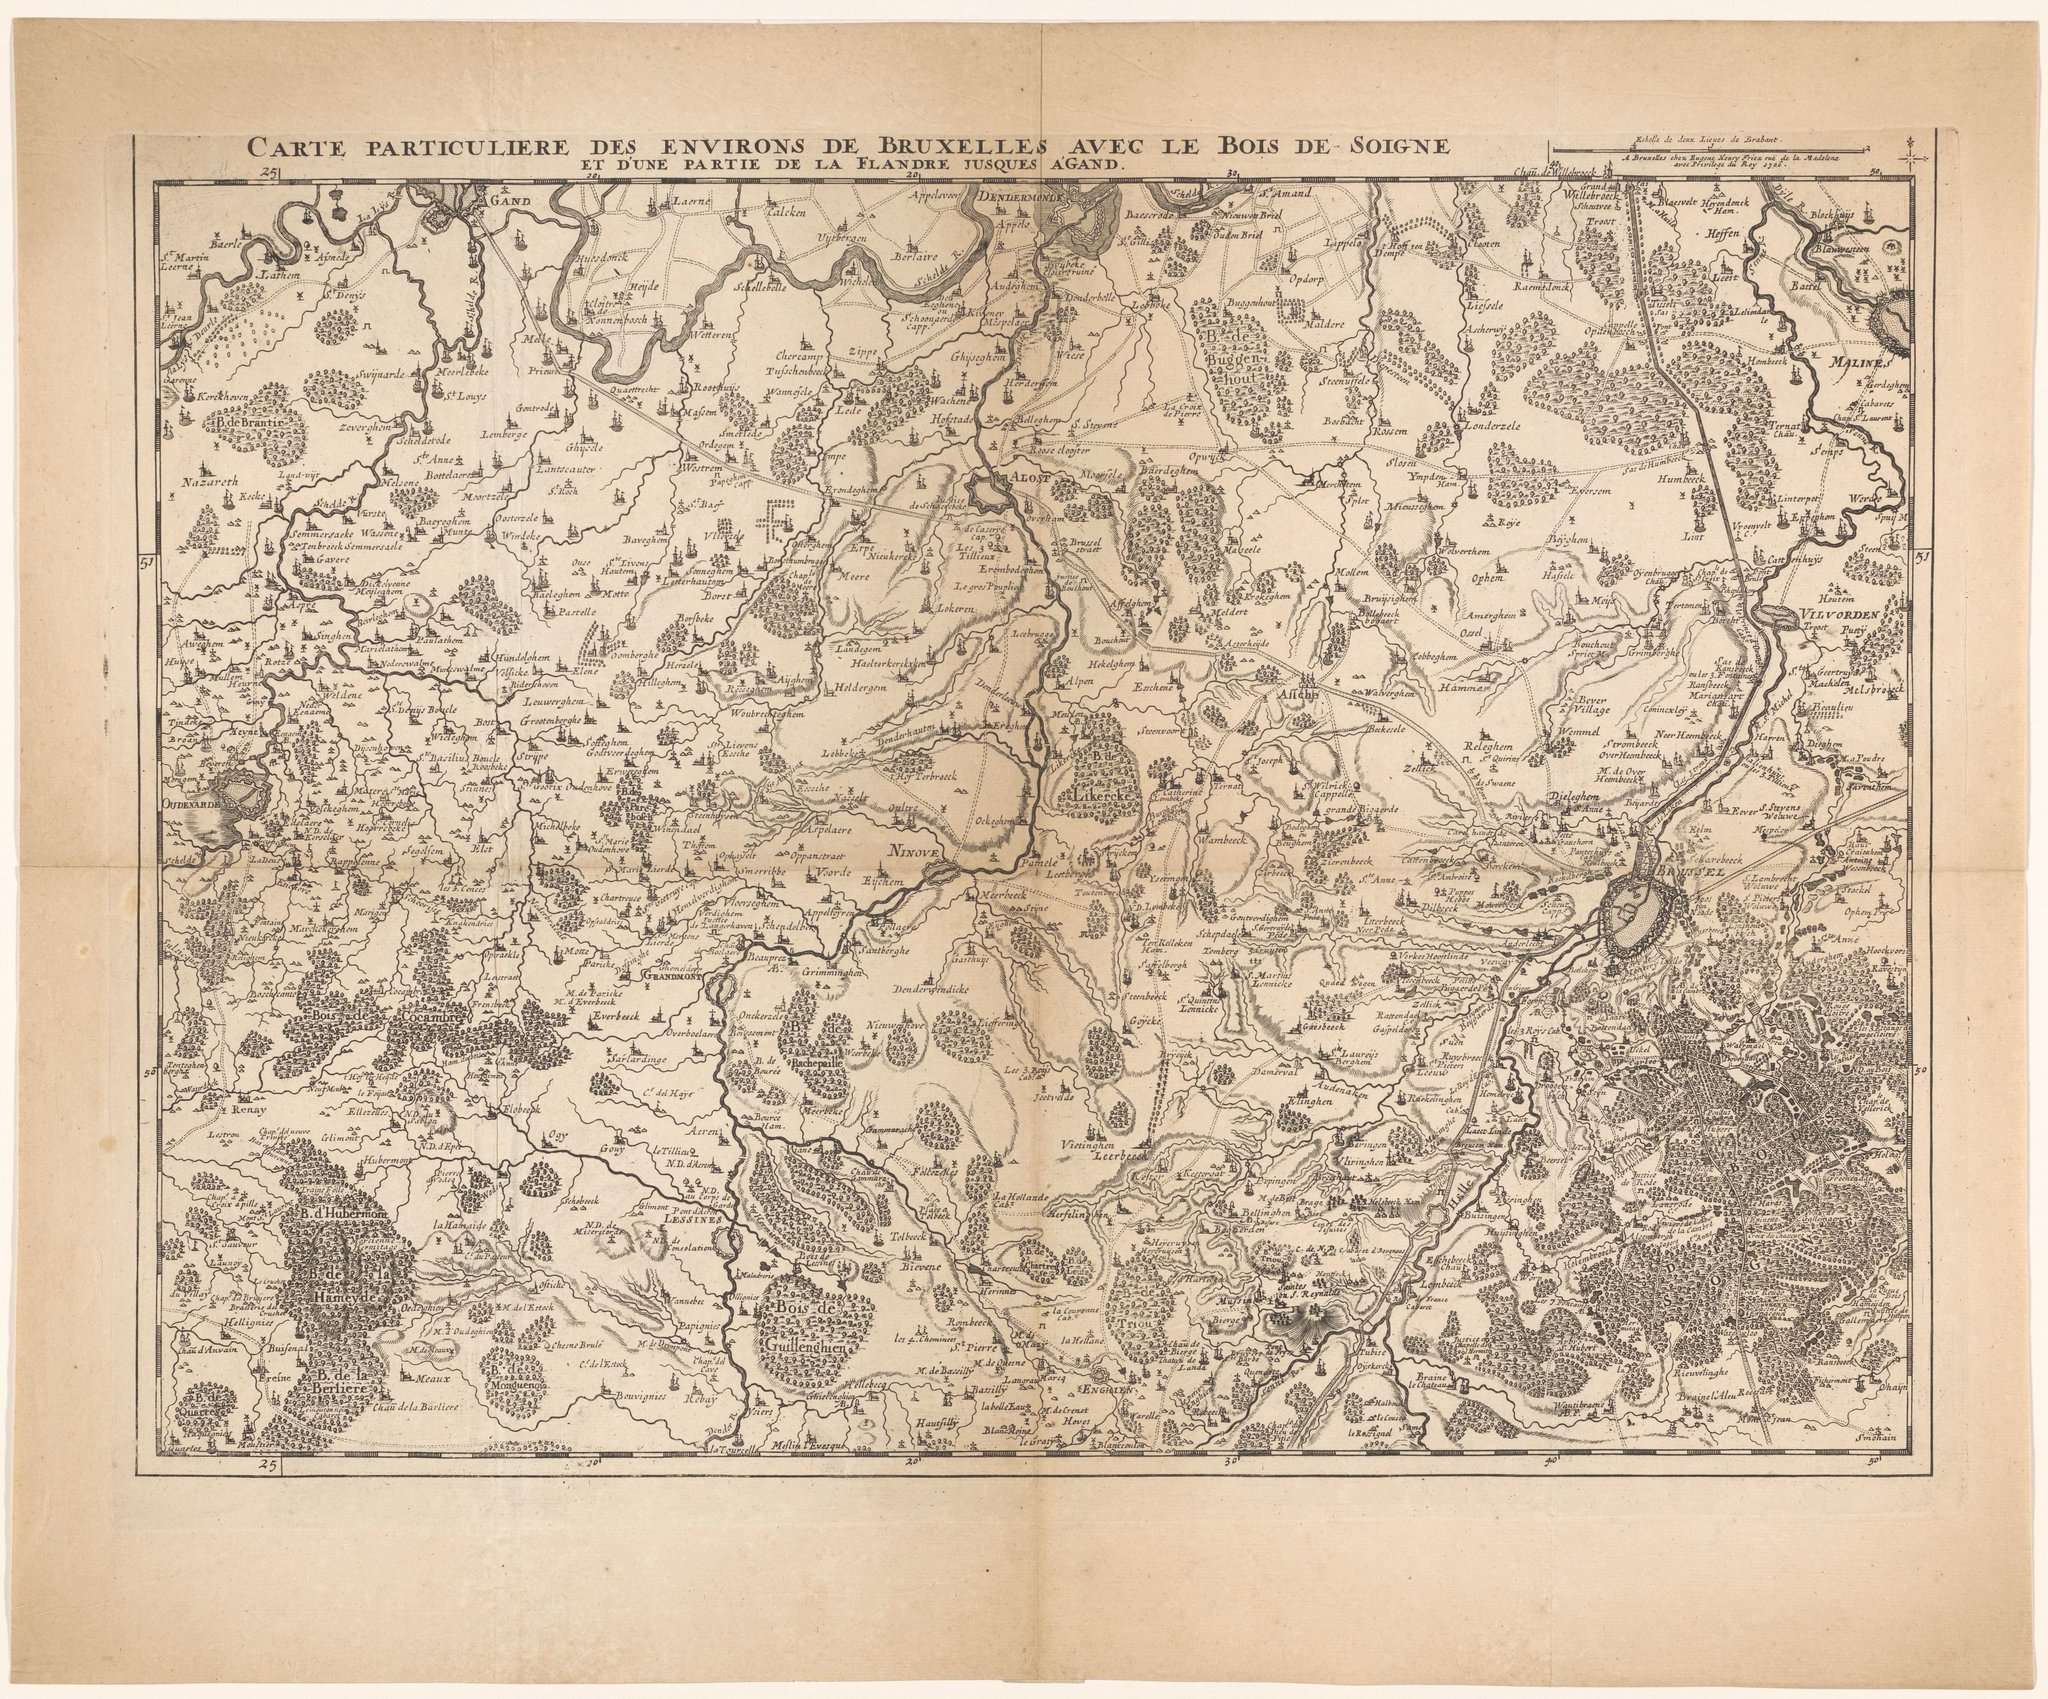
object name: map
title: Carte particuliere des environs de Bruxelles avec le Bois de Soigne (...)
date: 1708-1712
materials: paper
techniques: engraving, etching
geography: brussels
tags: marine charts, brabant, brussels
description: Prent ook gebruikt in: Table des cartes des Pays Bas et des frontières de France, avec un recueil des plans des villes, sièges et battailles données entre les hauts alliés et la France. Brussel: Eugene Henry Fricx, 1712. Bovenstaande publicatie kent meerdere drukken waarbij datum onveranderd is gebleven.